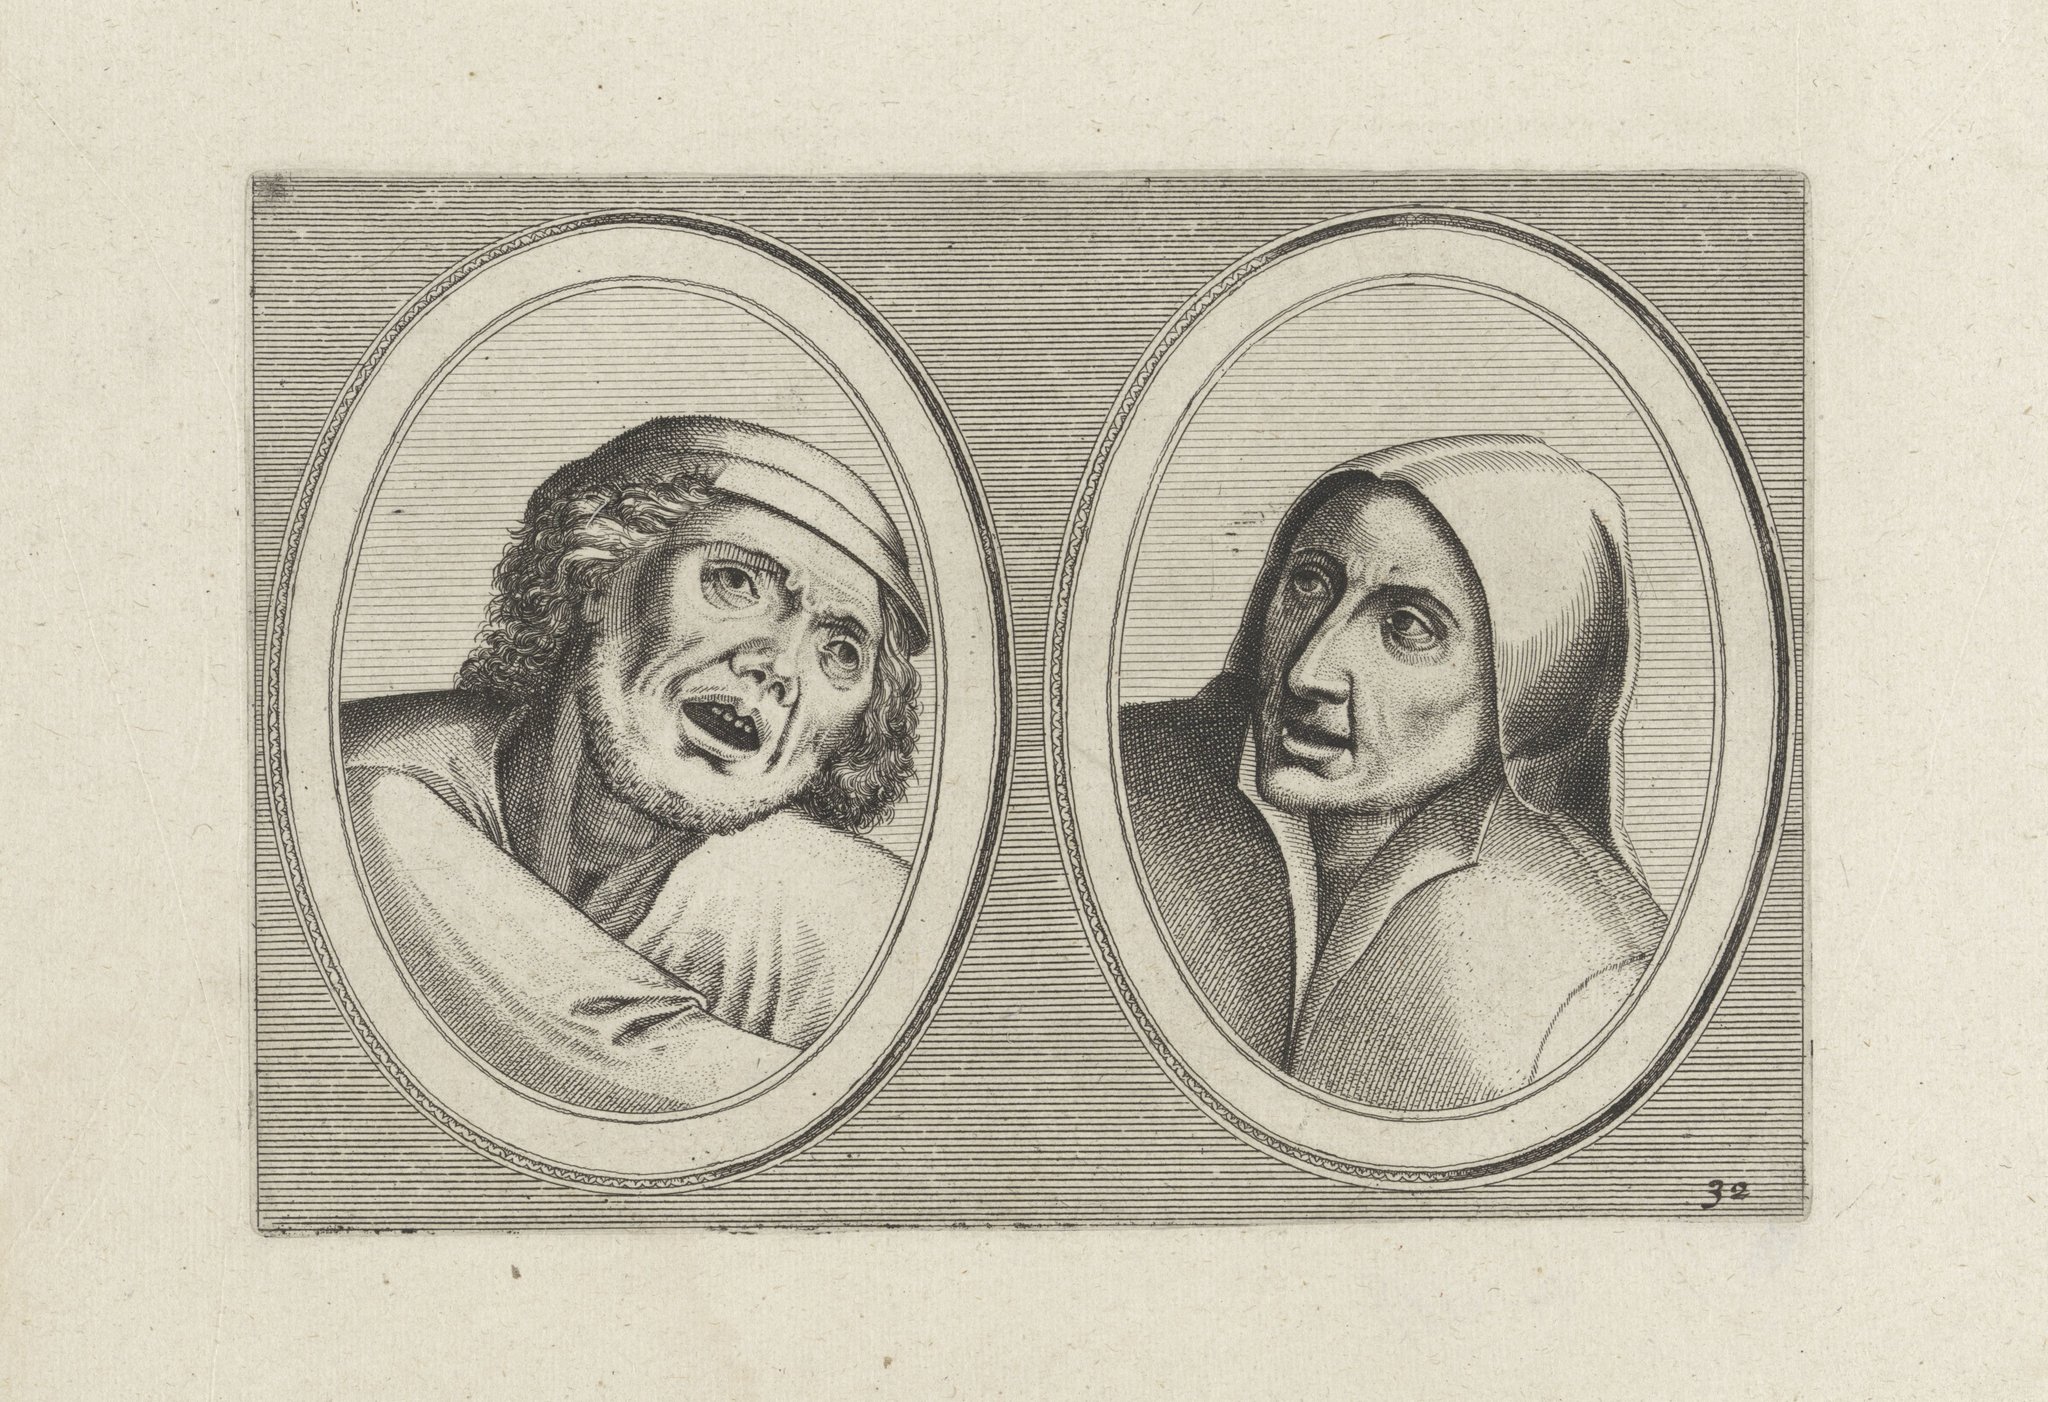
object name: print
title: Harme Snap-op en Keursje-sonder-naed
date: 1612-1652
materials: paper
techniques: engraving, etching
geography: amsterdam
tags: head-gear, farmers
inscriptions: collector's mark: Lugt 700, collector's mark: Lugt 240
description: Prent uit een serie van 36 prenten met koppen van boeren en boerinnen.